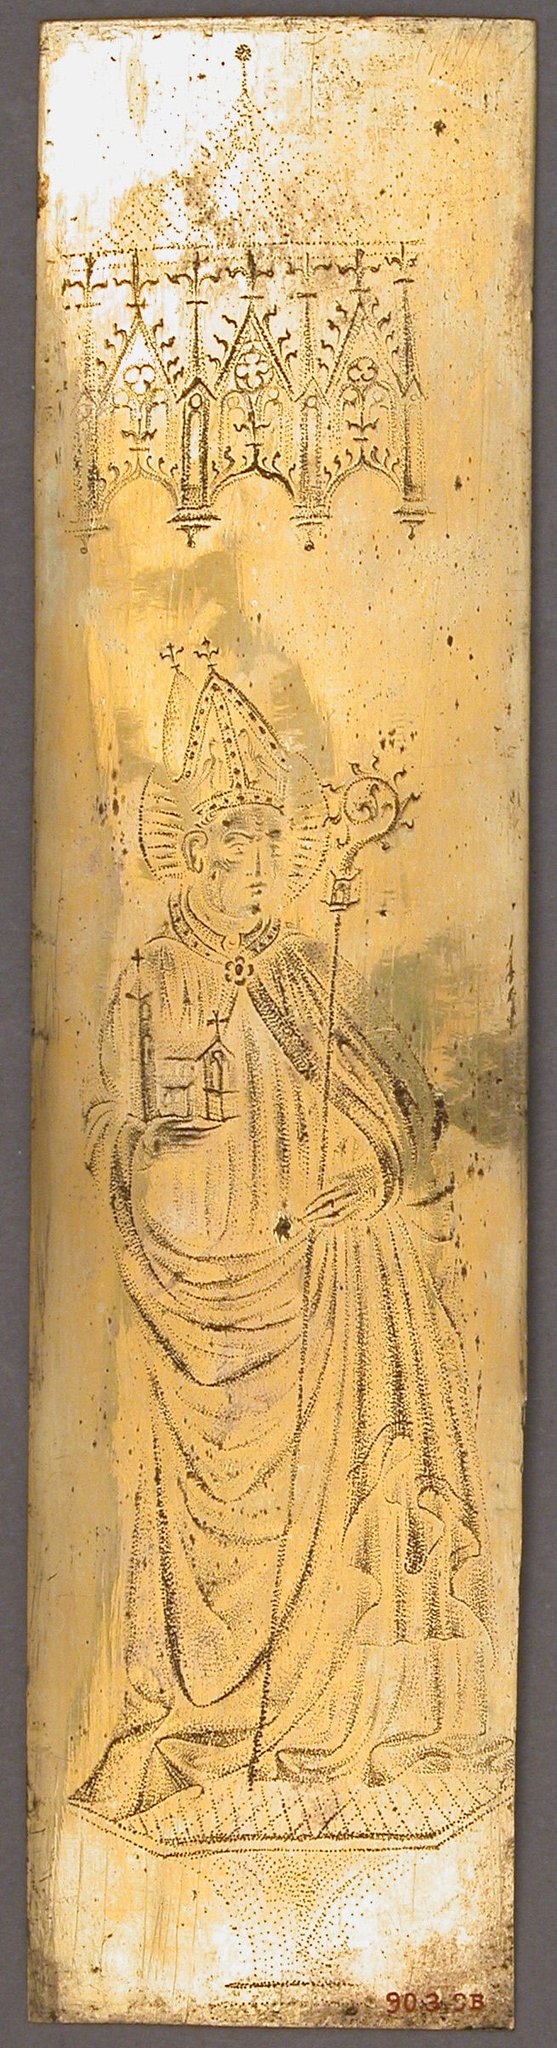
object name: triptych wing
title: Panel from a Triptych with Bishop Saint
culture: german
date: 1434-1466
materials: gilt copper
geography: germany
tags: bishops,saints